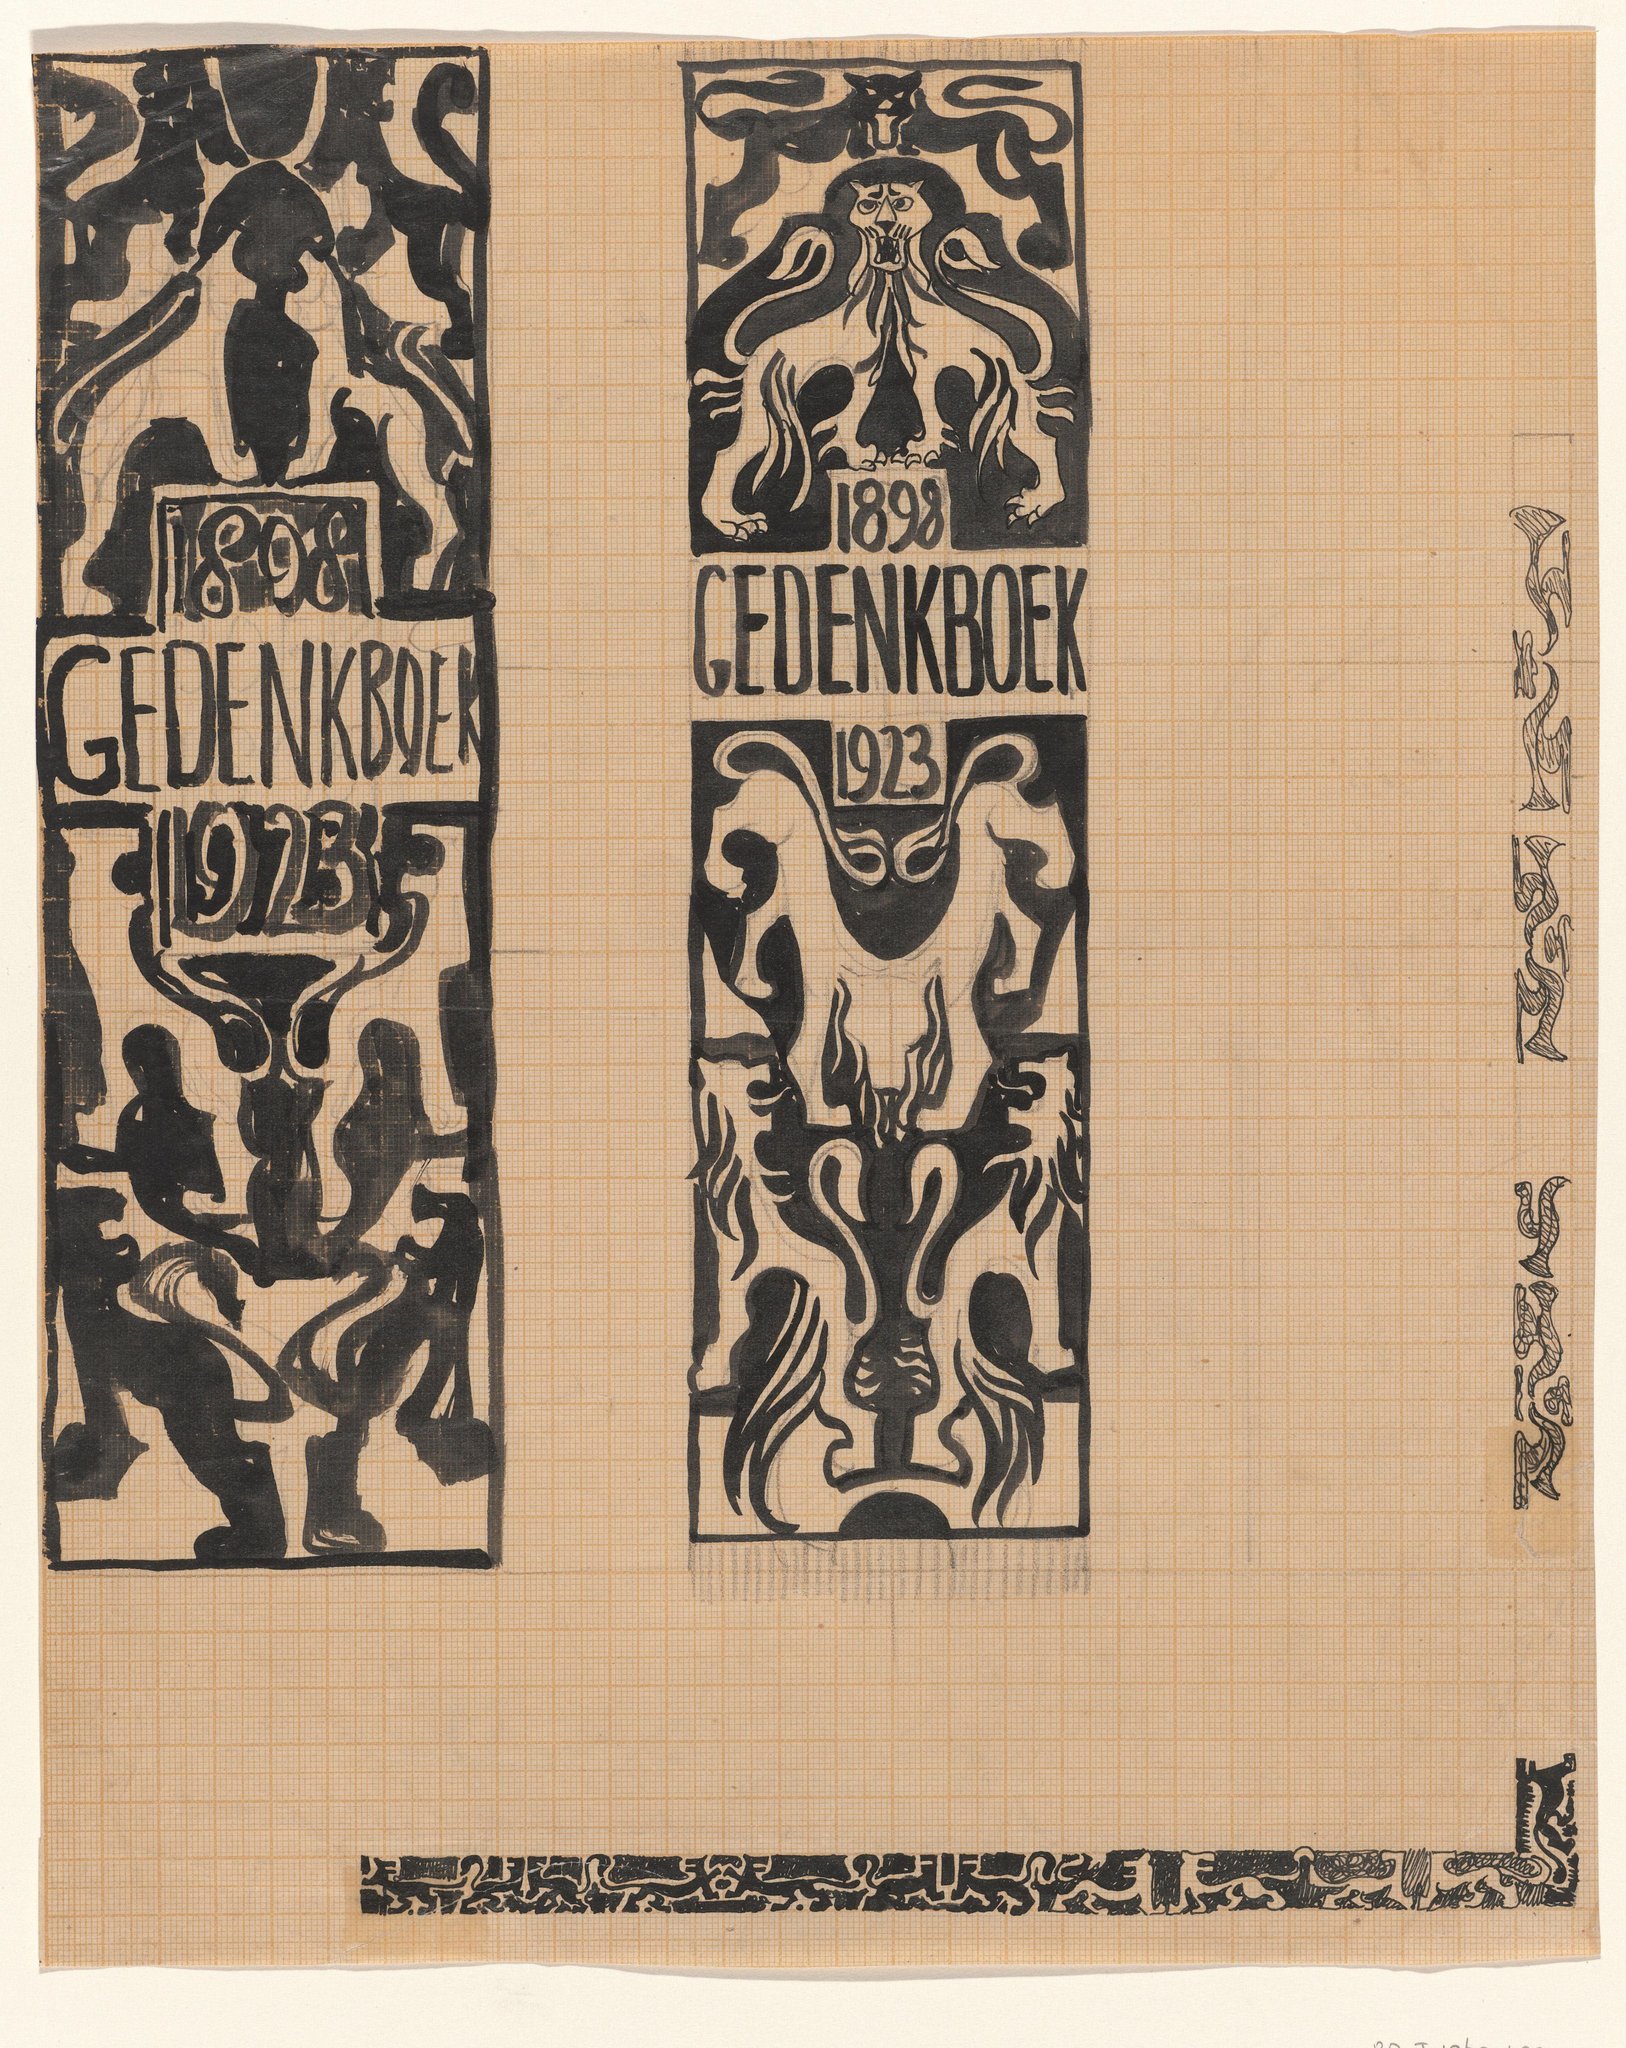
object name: drawing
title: Twee ontwerpen voor de rug van het gedenkboek voor koningin Wilhelmina uit 1923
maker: carel adolph lion cachet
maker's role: draughtsman, print maker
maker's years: 1864-1945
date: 1874-1945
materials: pencil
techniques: brush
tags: other ornament derived from animal forms - aa - stylized, beasts of prey, predatory animals: lion